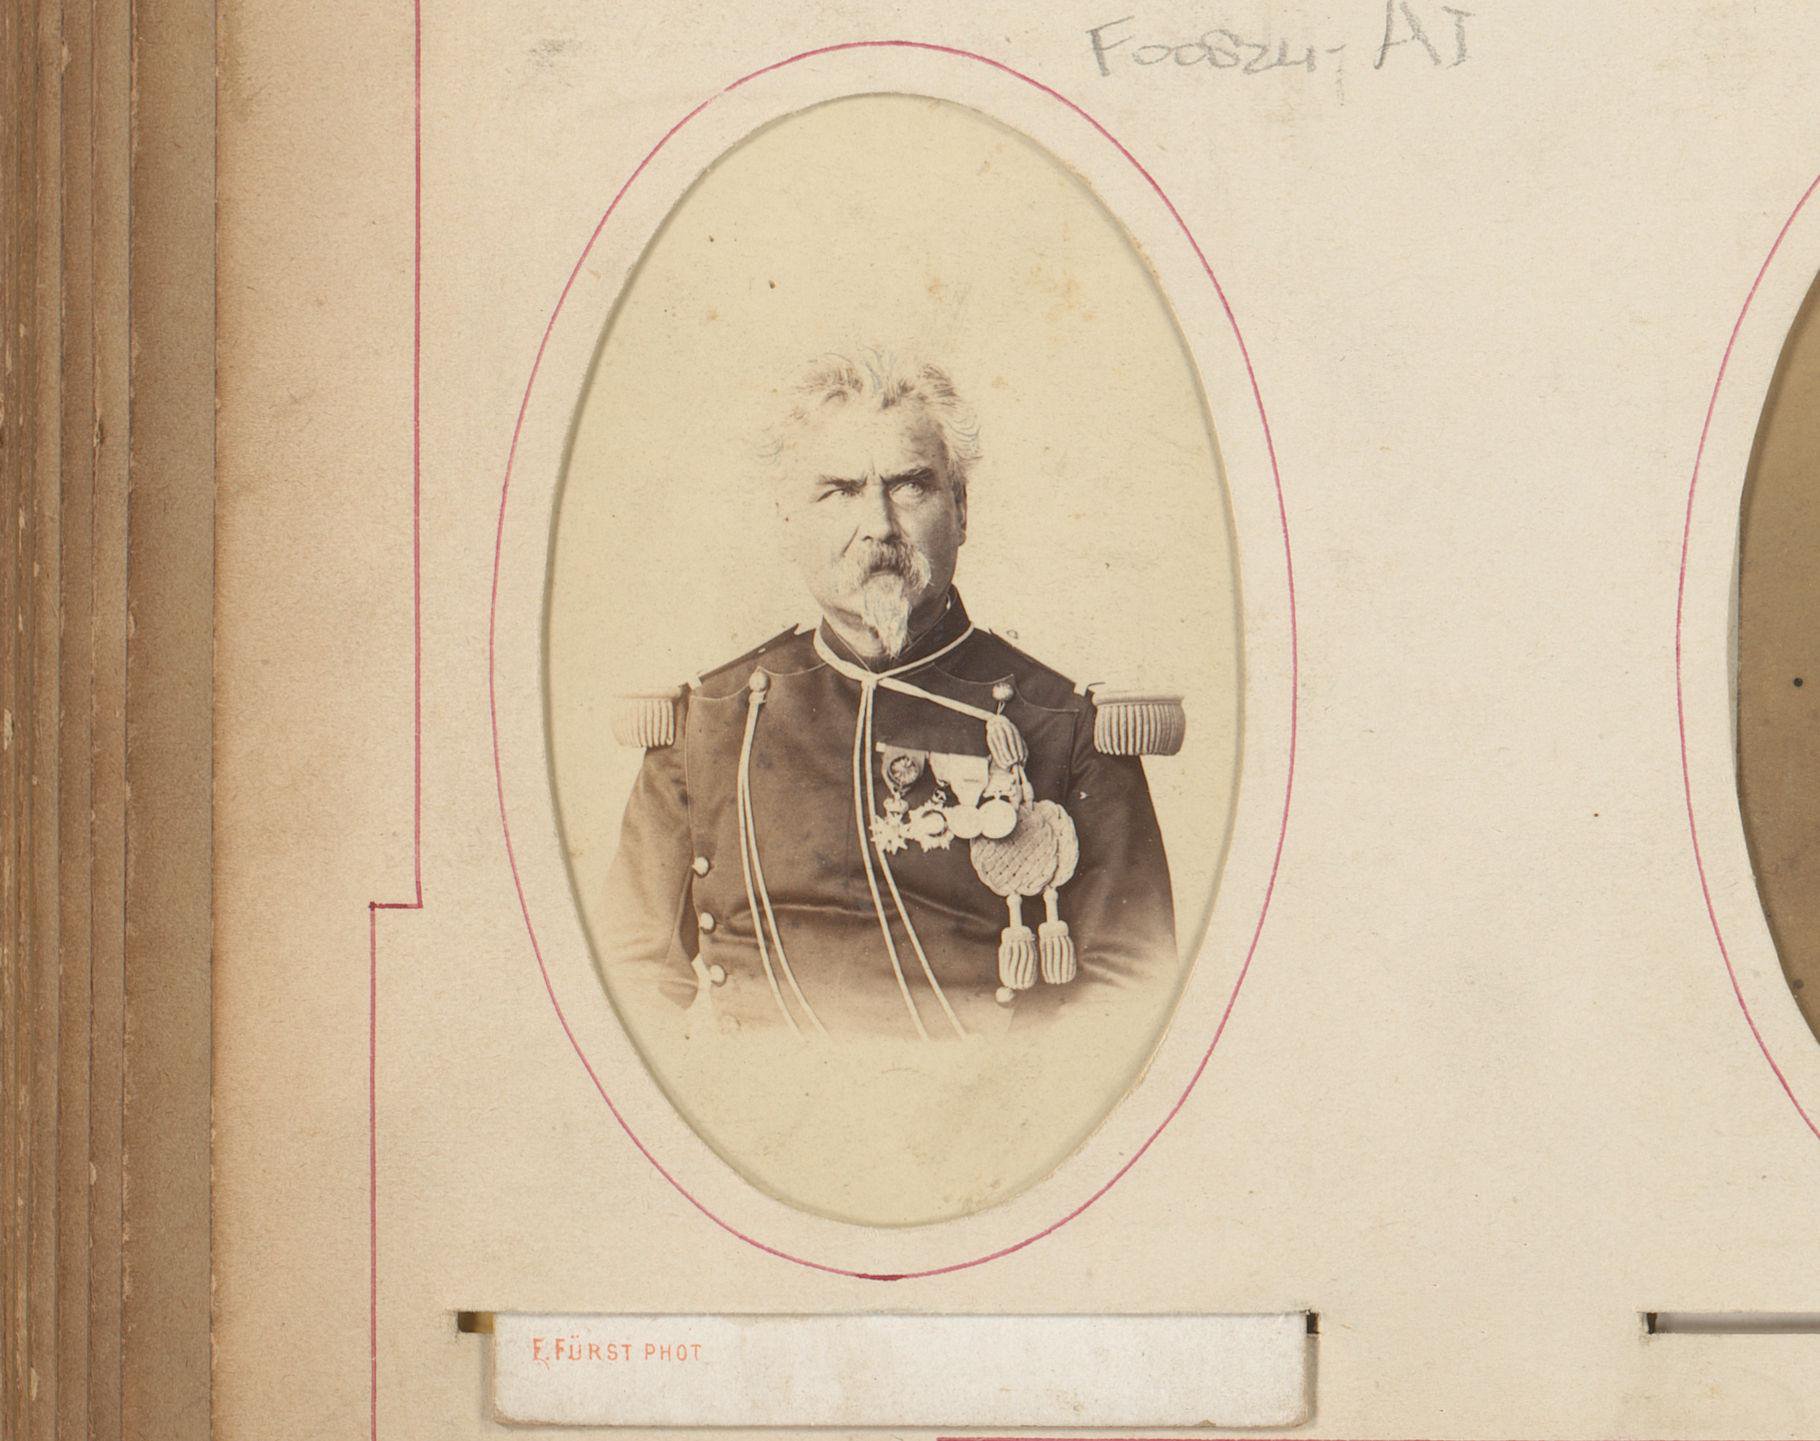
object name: photograph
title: Portret van een onbekende man in militair uniform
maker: émile fürst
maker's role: fotograaf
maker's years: 1834-1922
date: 1864-1885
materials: cardboard, paper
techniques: albumen print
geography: nantes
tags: adult man, anonymous historical person portrayed, (military) uniforms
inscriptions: address: ‘17, rue de Feltre, 17./ en face le musée/ MAISON SÉCHEZ DESBOIS/ NANTES.’